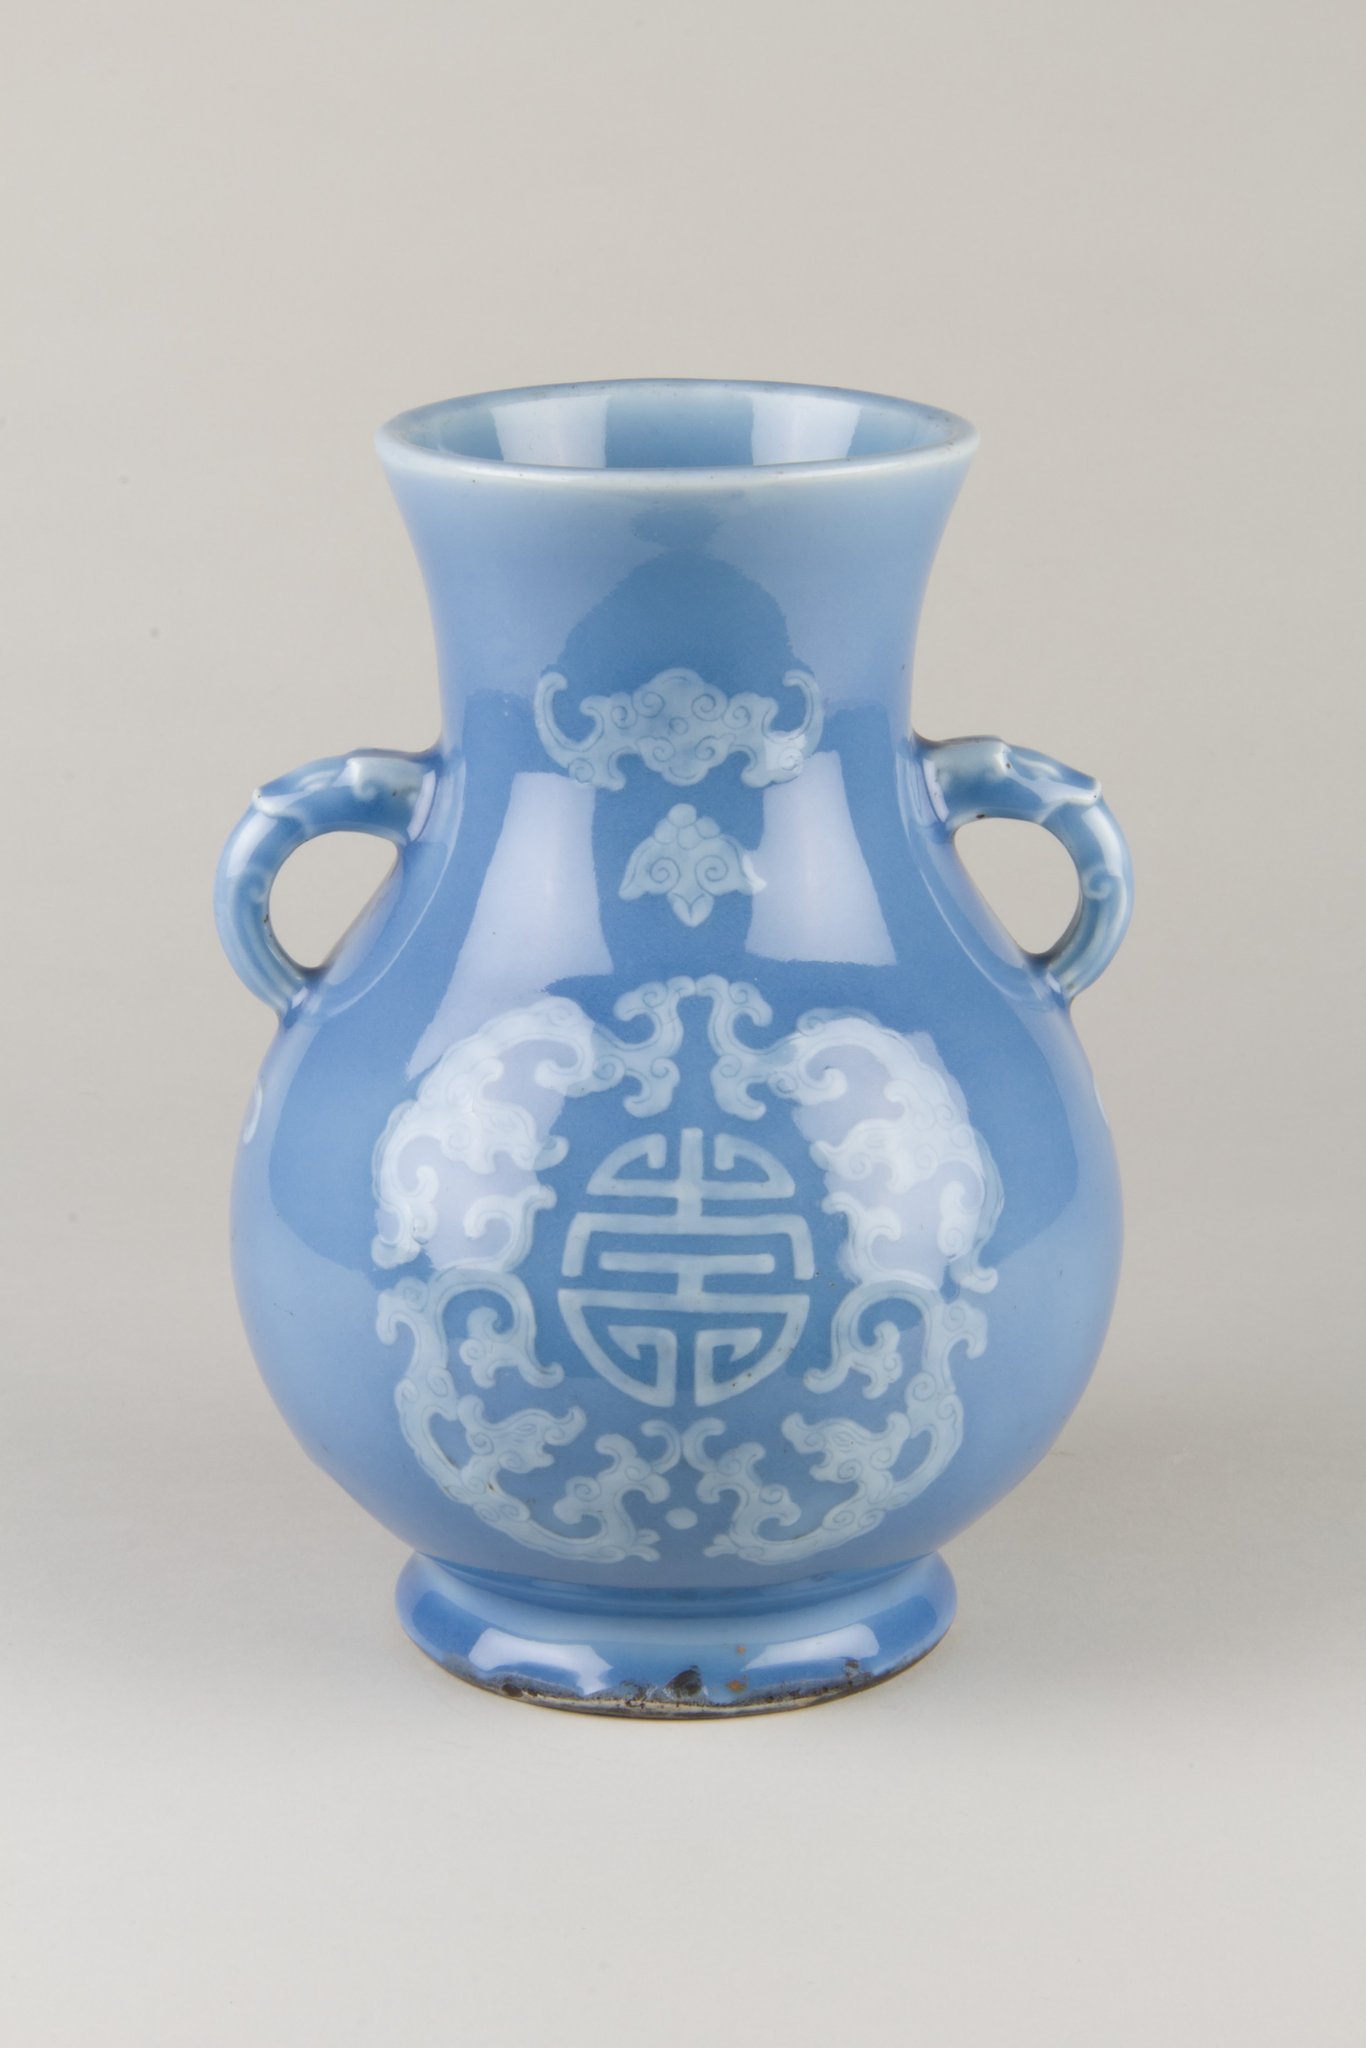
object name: vase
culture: chinese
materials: porcelain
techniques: relief